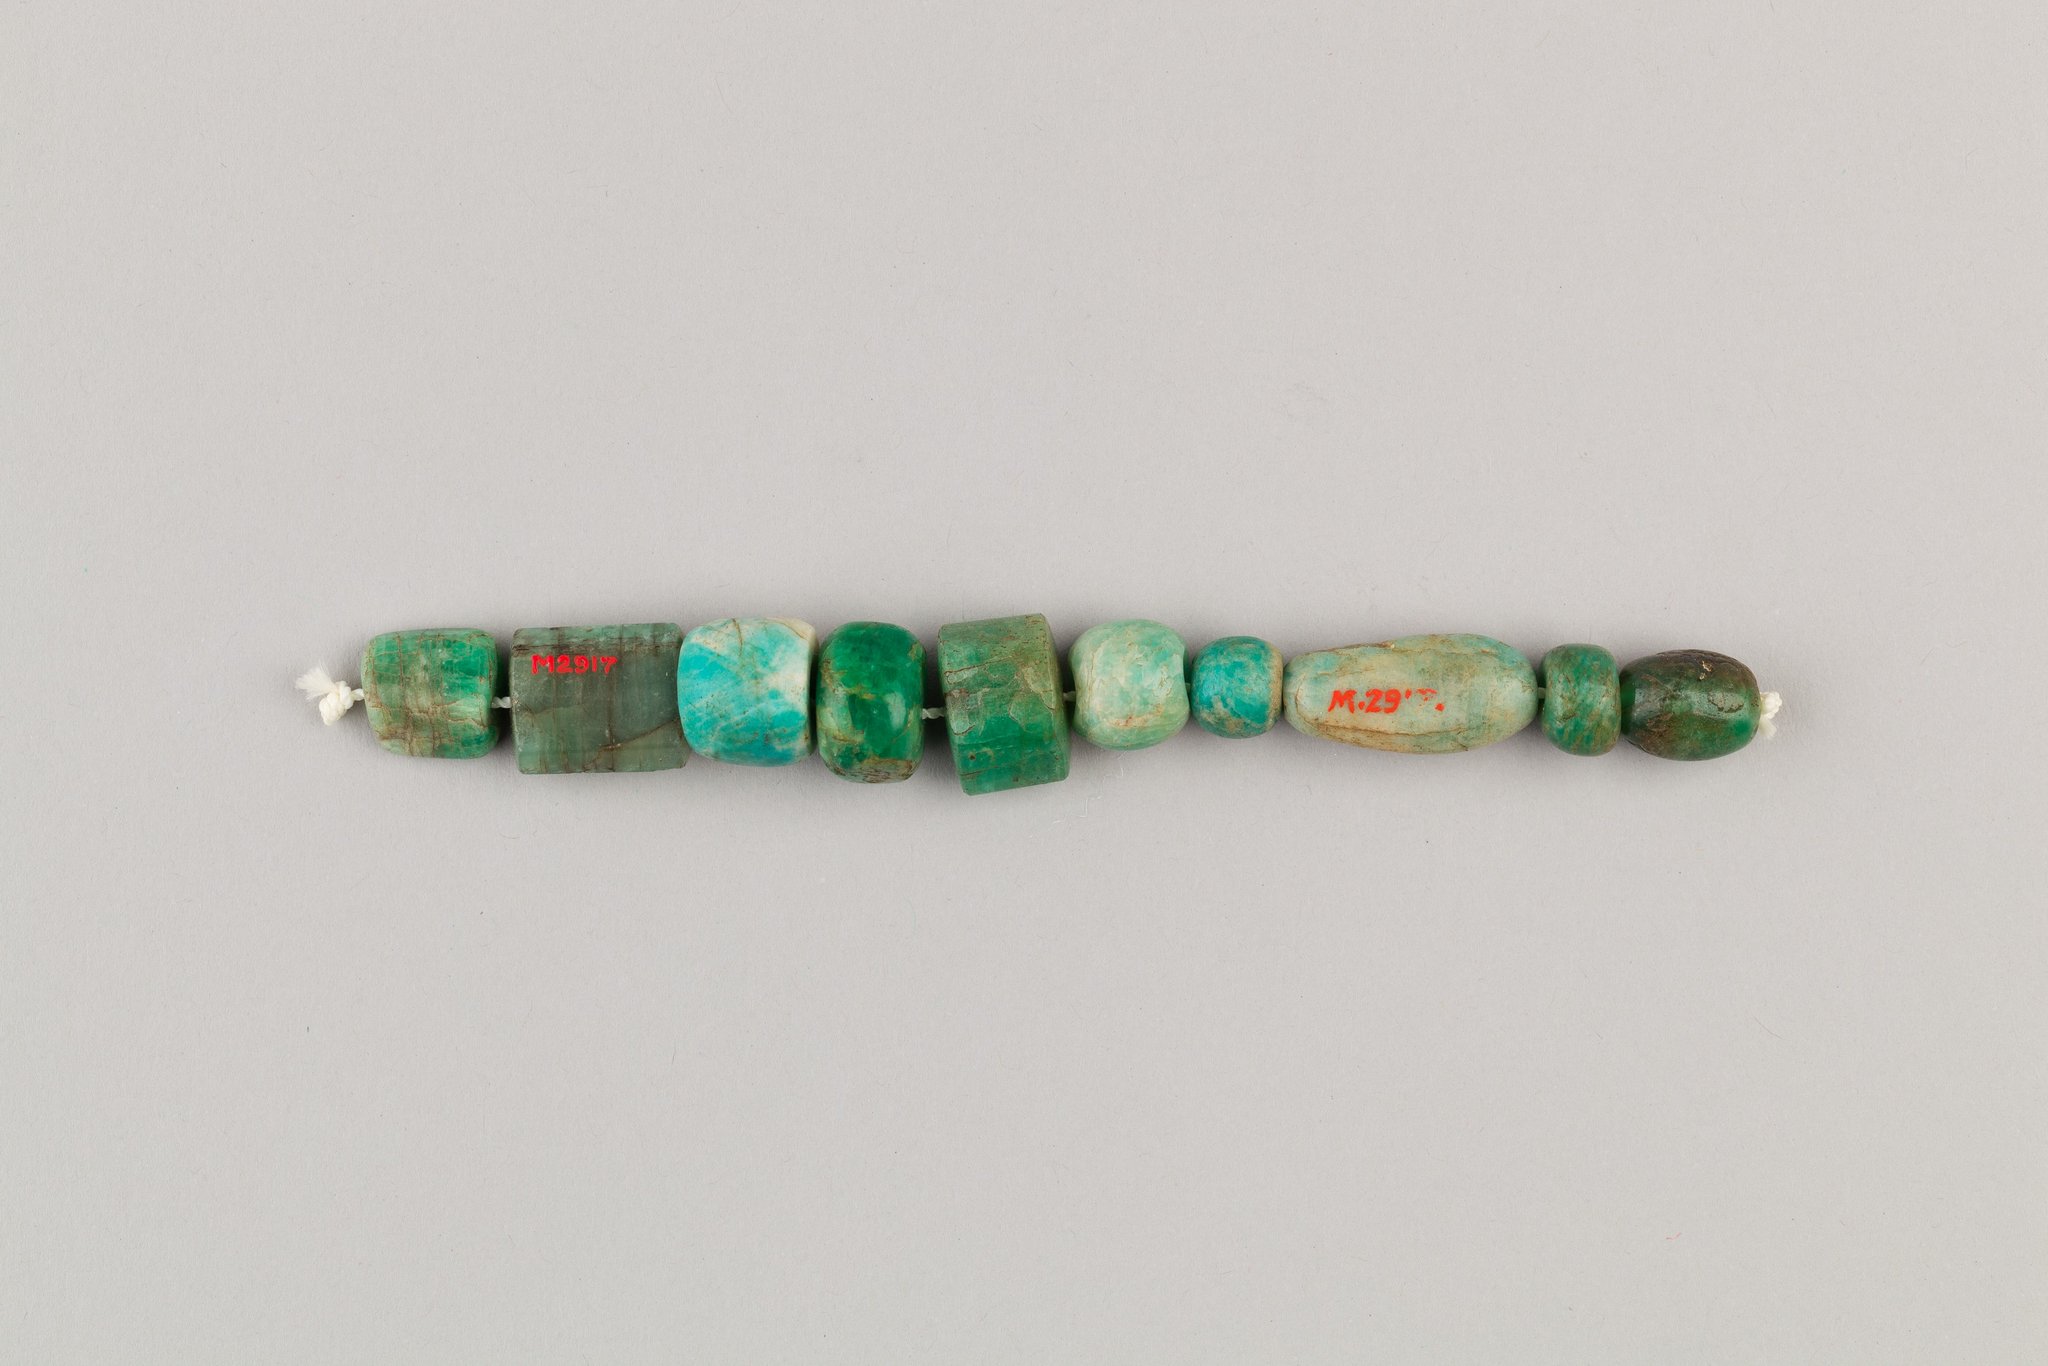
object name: bead, string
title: String of 10 beads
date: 1-100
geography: egypt